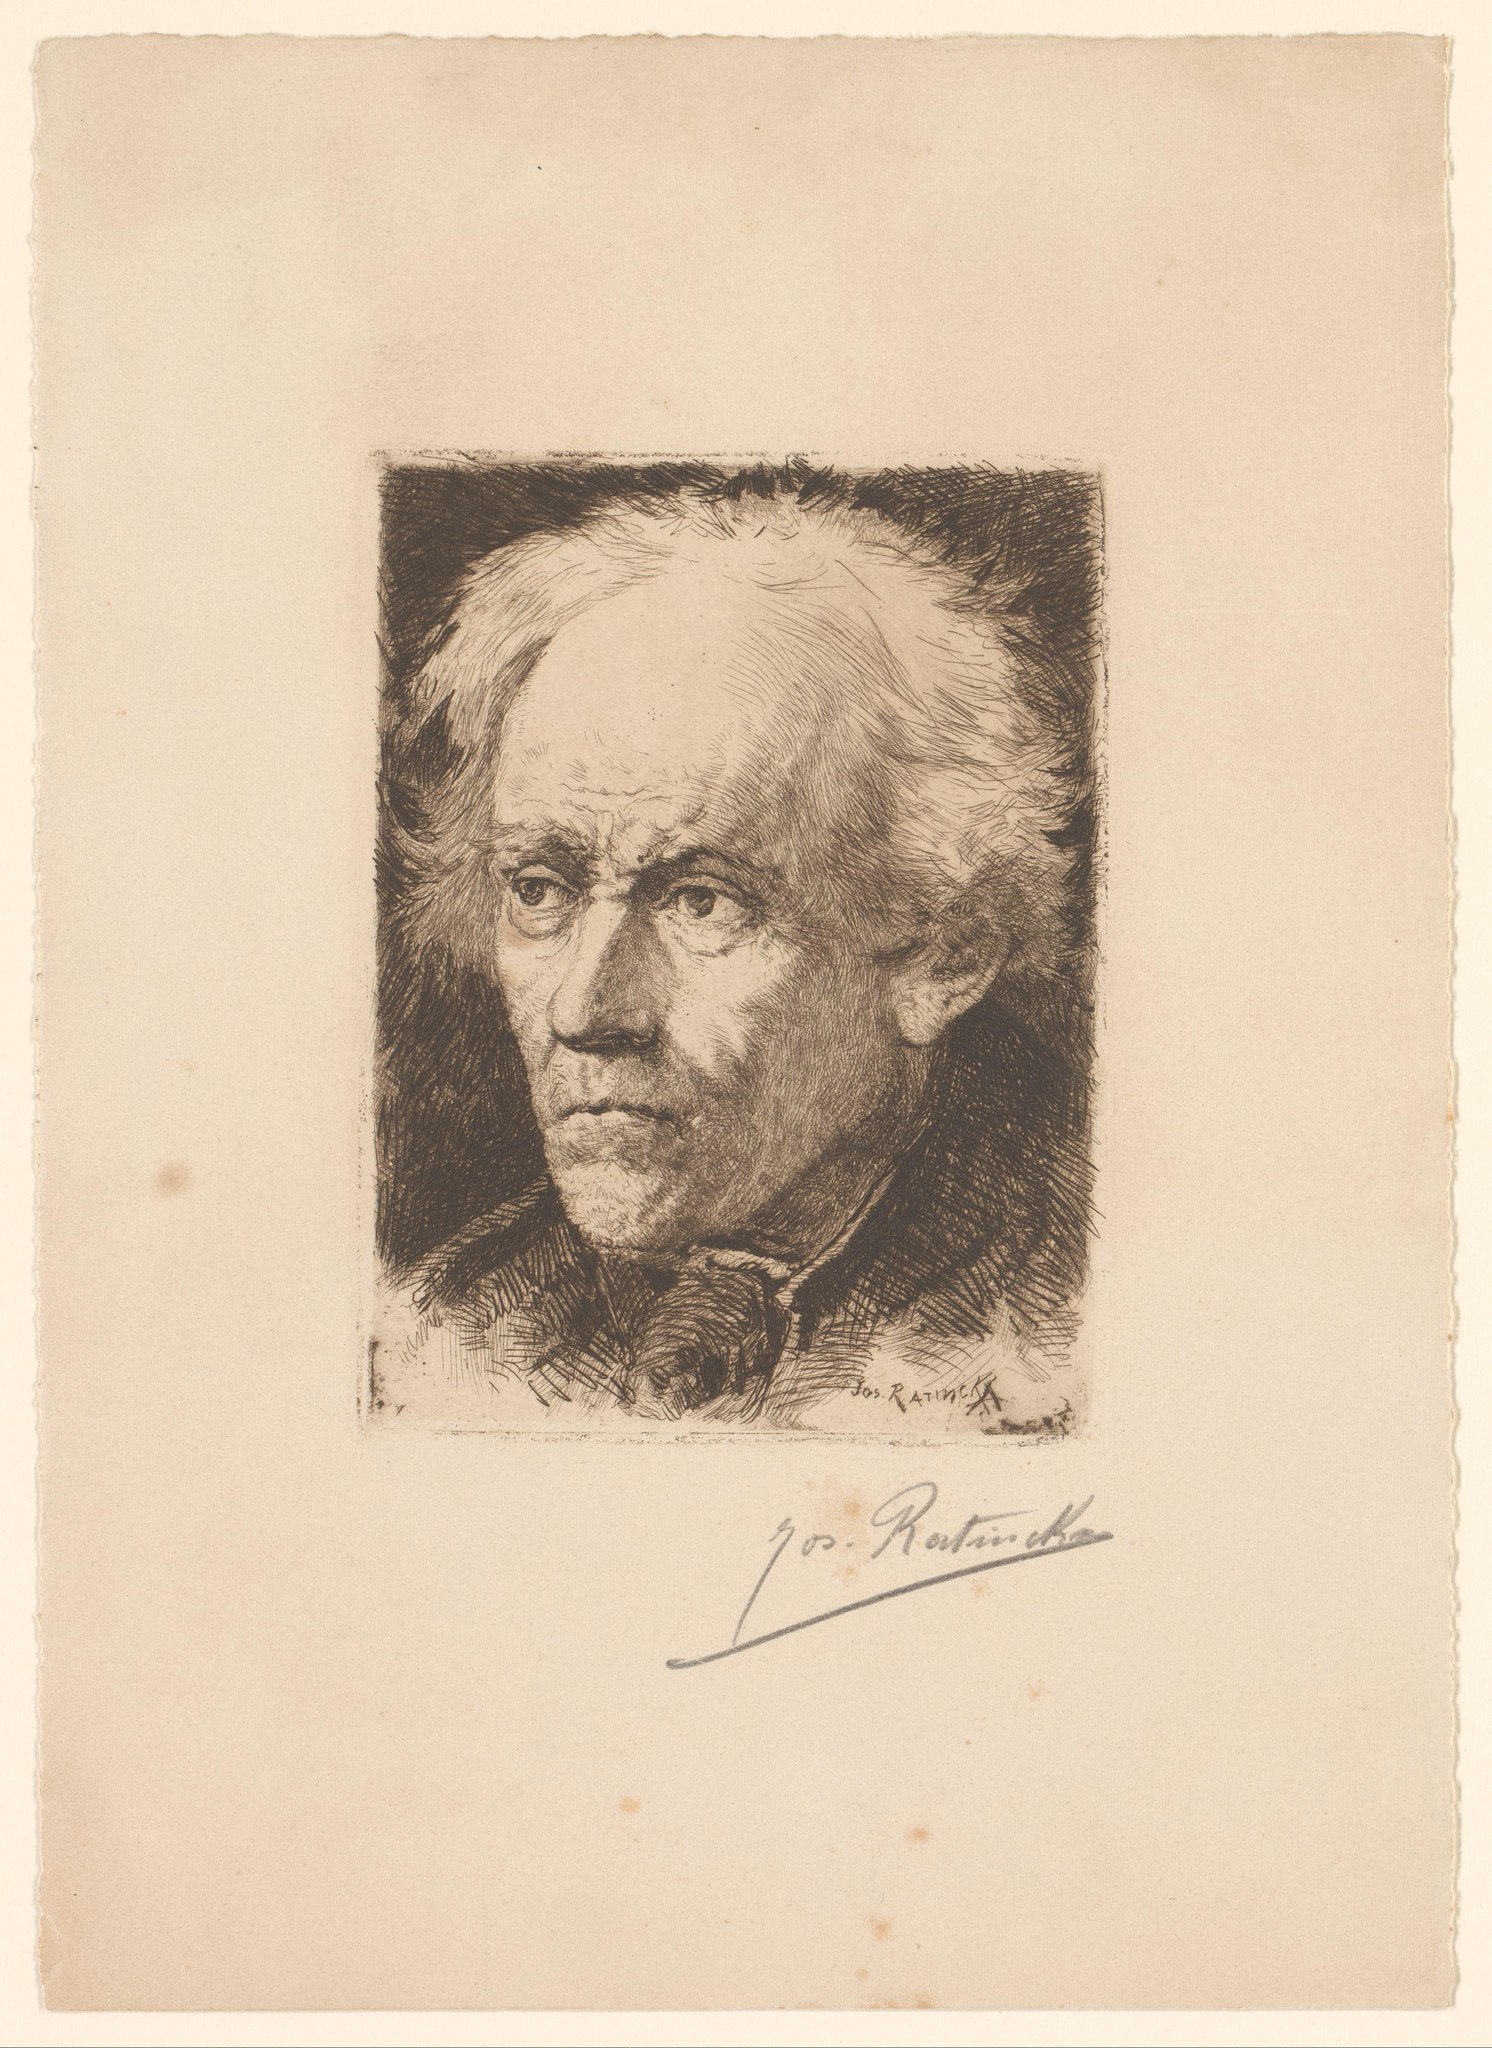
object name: print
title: Hoofd van een oude man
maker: jos ratinckx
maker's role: print maker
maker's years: 1860-1937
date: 1870-1913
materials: paper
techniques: etching, retroussage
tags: old man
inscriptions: collector's mark: Lugt 2228